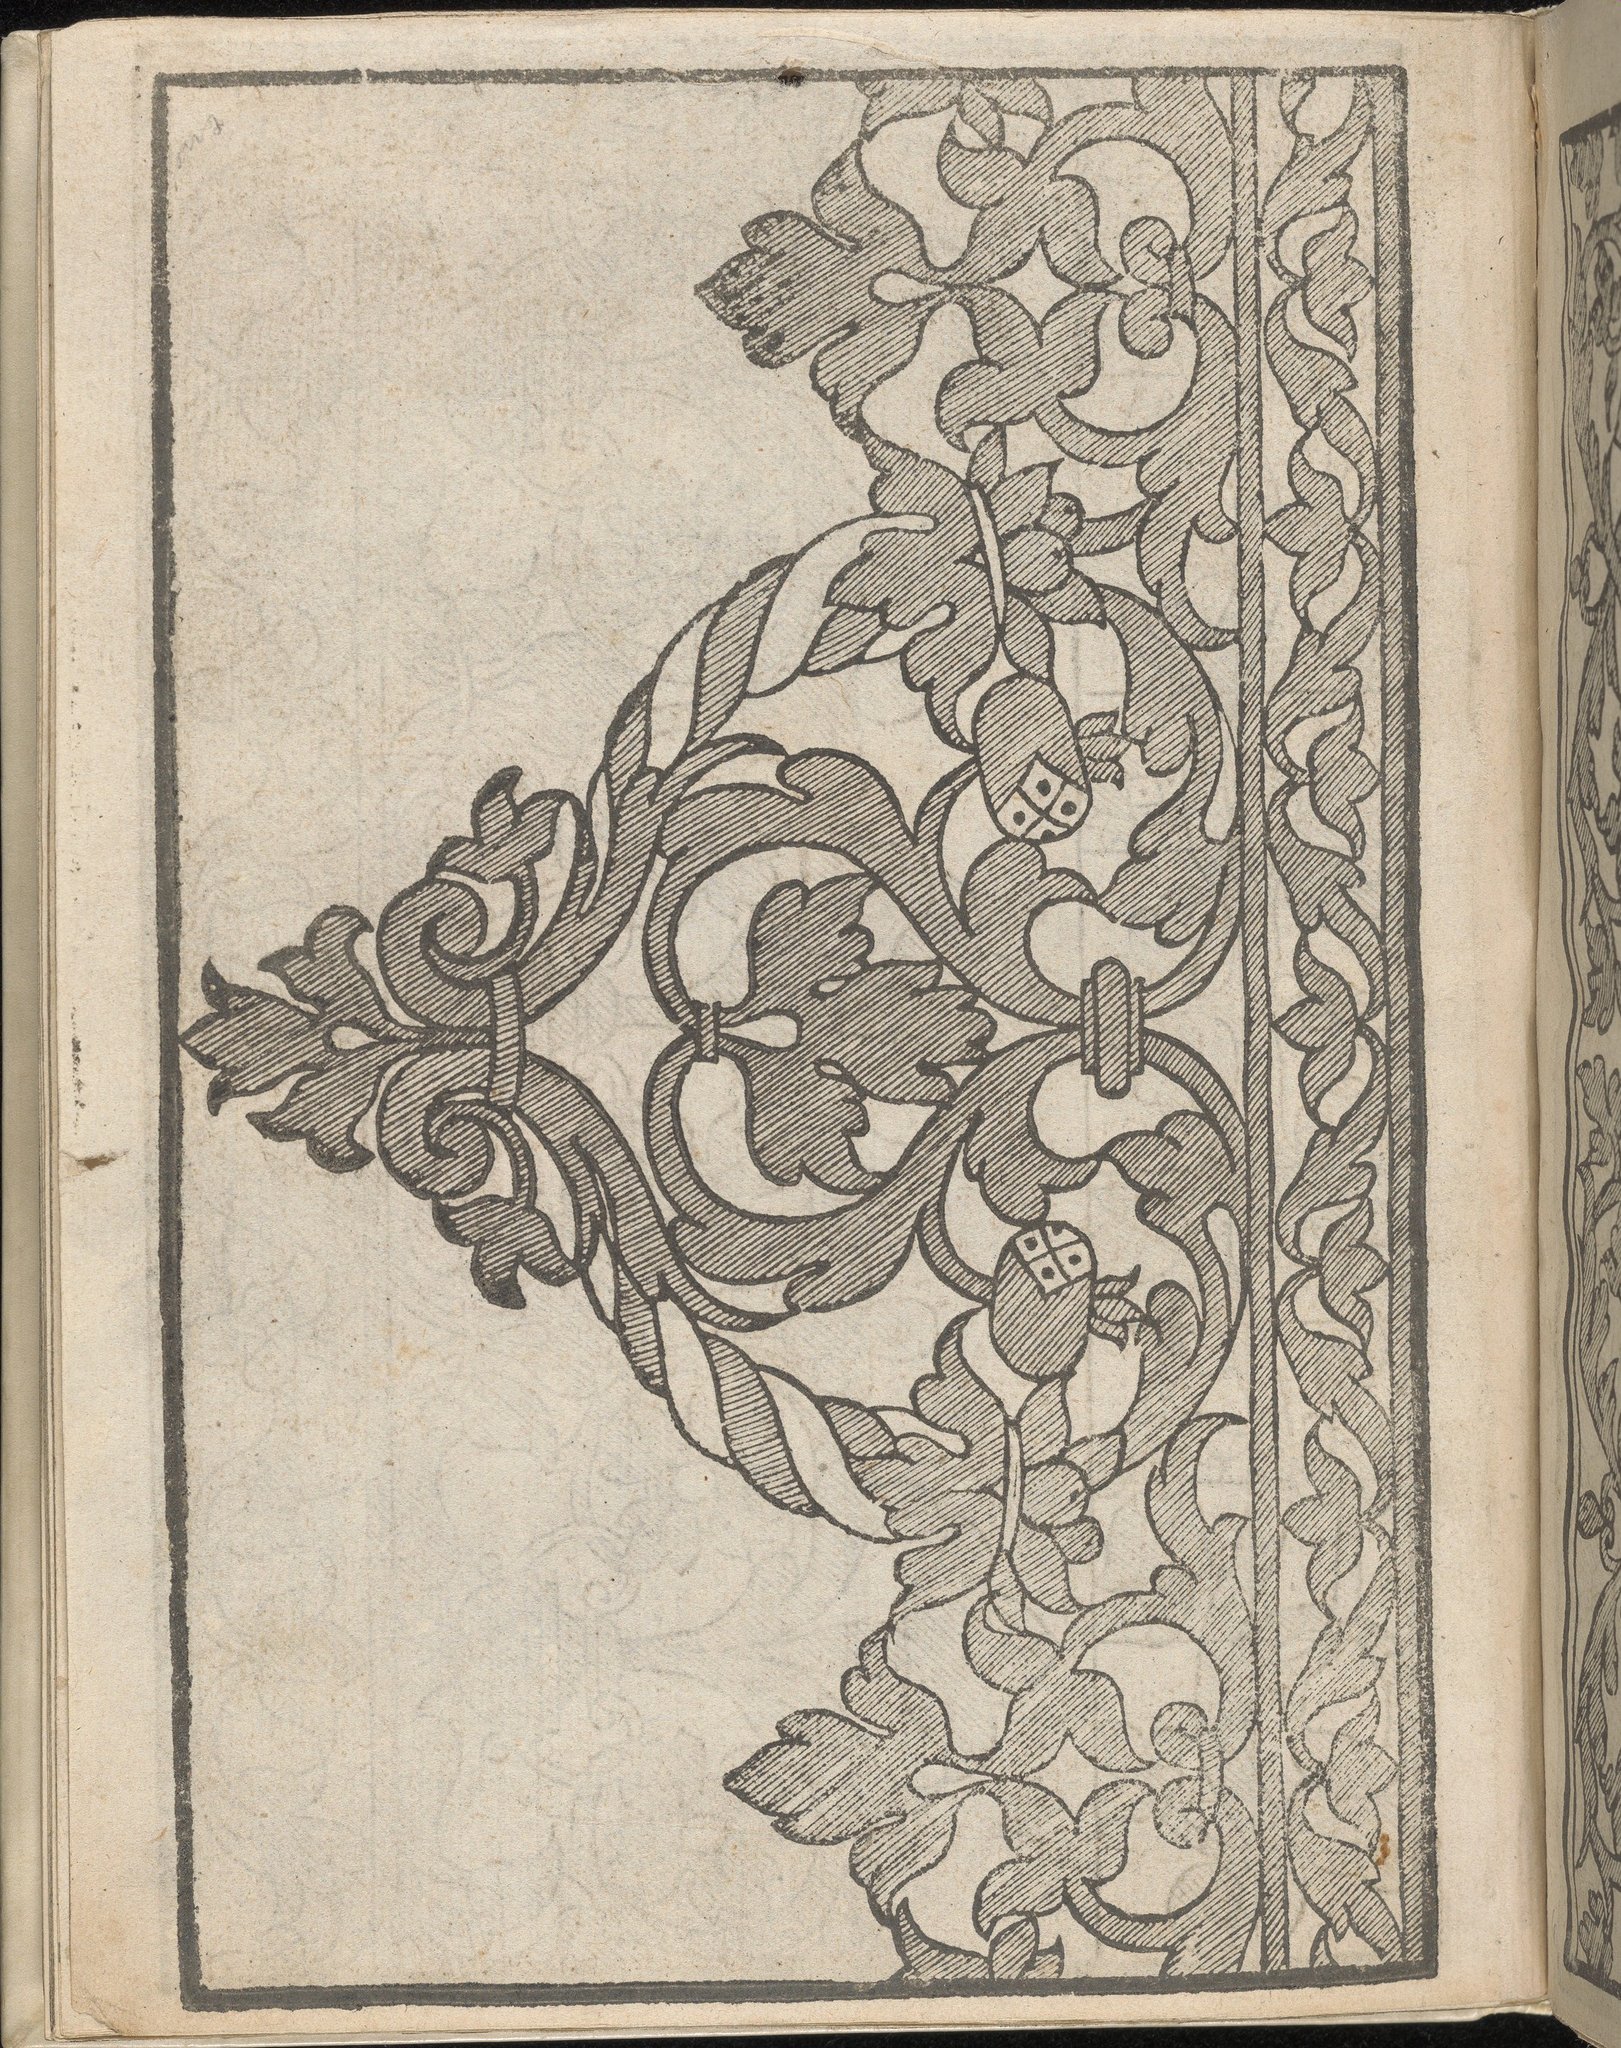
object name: book print ornament architecture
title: Lucidario di Recami, page 6 (verso)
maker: iseppo foresto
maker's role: designer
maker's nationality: italian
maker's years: 1520-1580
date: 1564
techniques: woodcut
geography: italy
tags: flowers